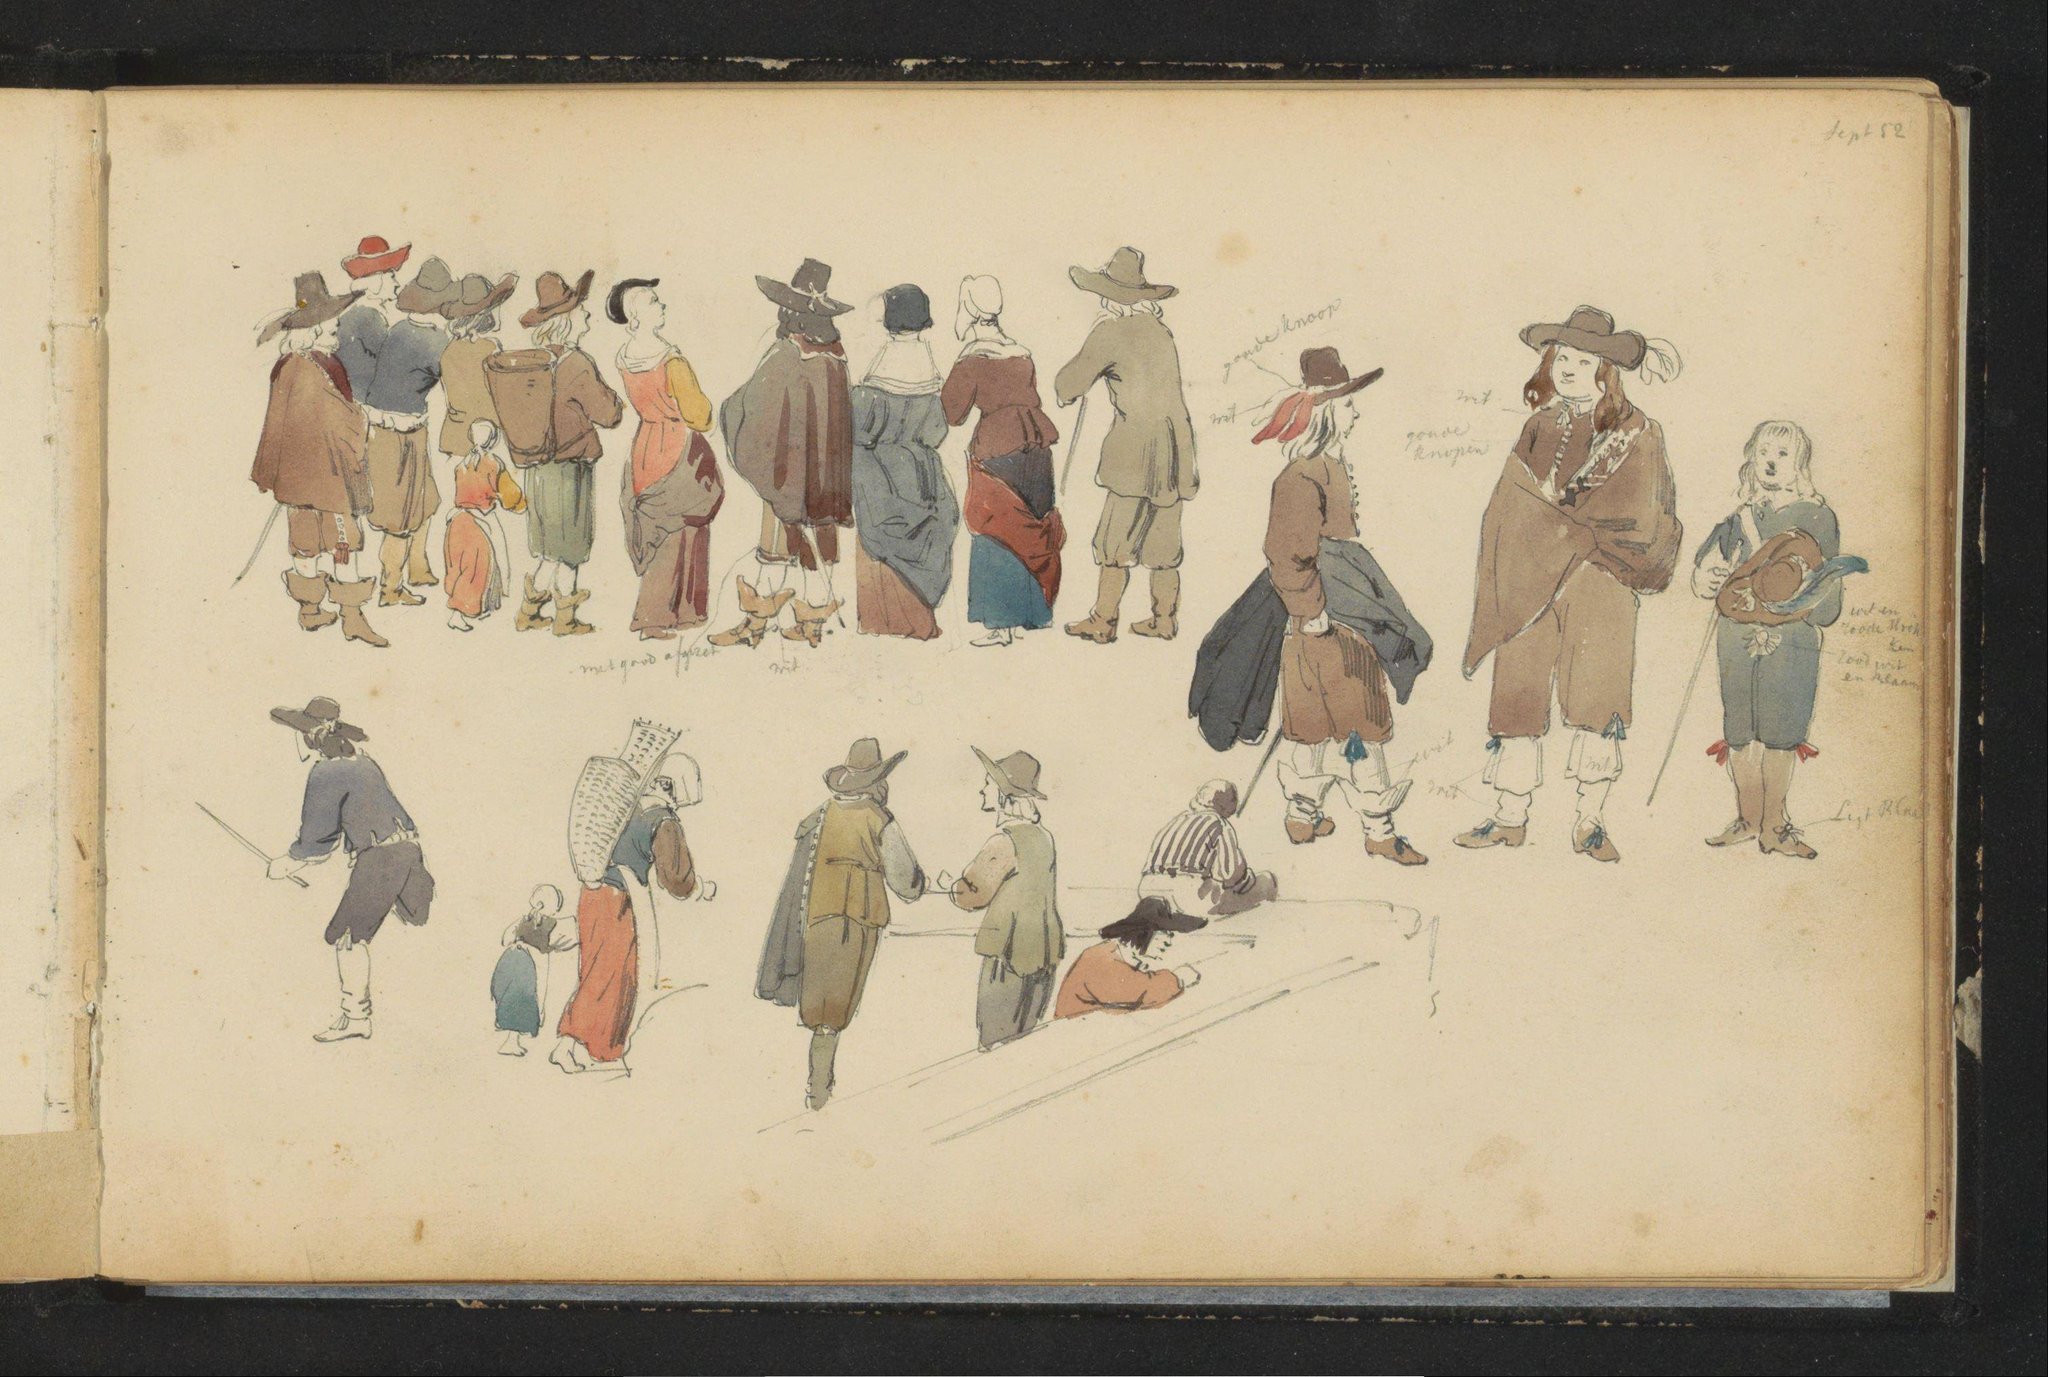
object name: sketchbook leaf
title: Figuren in zeventiende-eeuwse kleding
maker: cornelis springer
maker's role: draughtsman, painter, print maker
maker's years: 1817-1891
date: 1809-1852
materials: paper, pencil, watercolor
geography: netherlands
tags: adult woman, adult man, child, pedlar, clothes, costume (+ women's clothes), clothes, costume (+ men's clothes)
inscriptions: date: ‘Sept 52’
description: Figuren, onder andere marskramers, in zeventiende-eeuwse kleding. Blad 14 uit een schetsboek met 91 bladen.